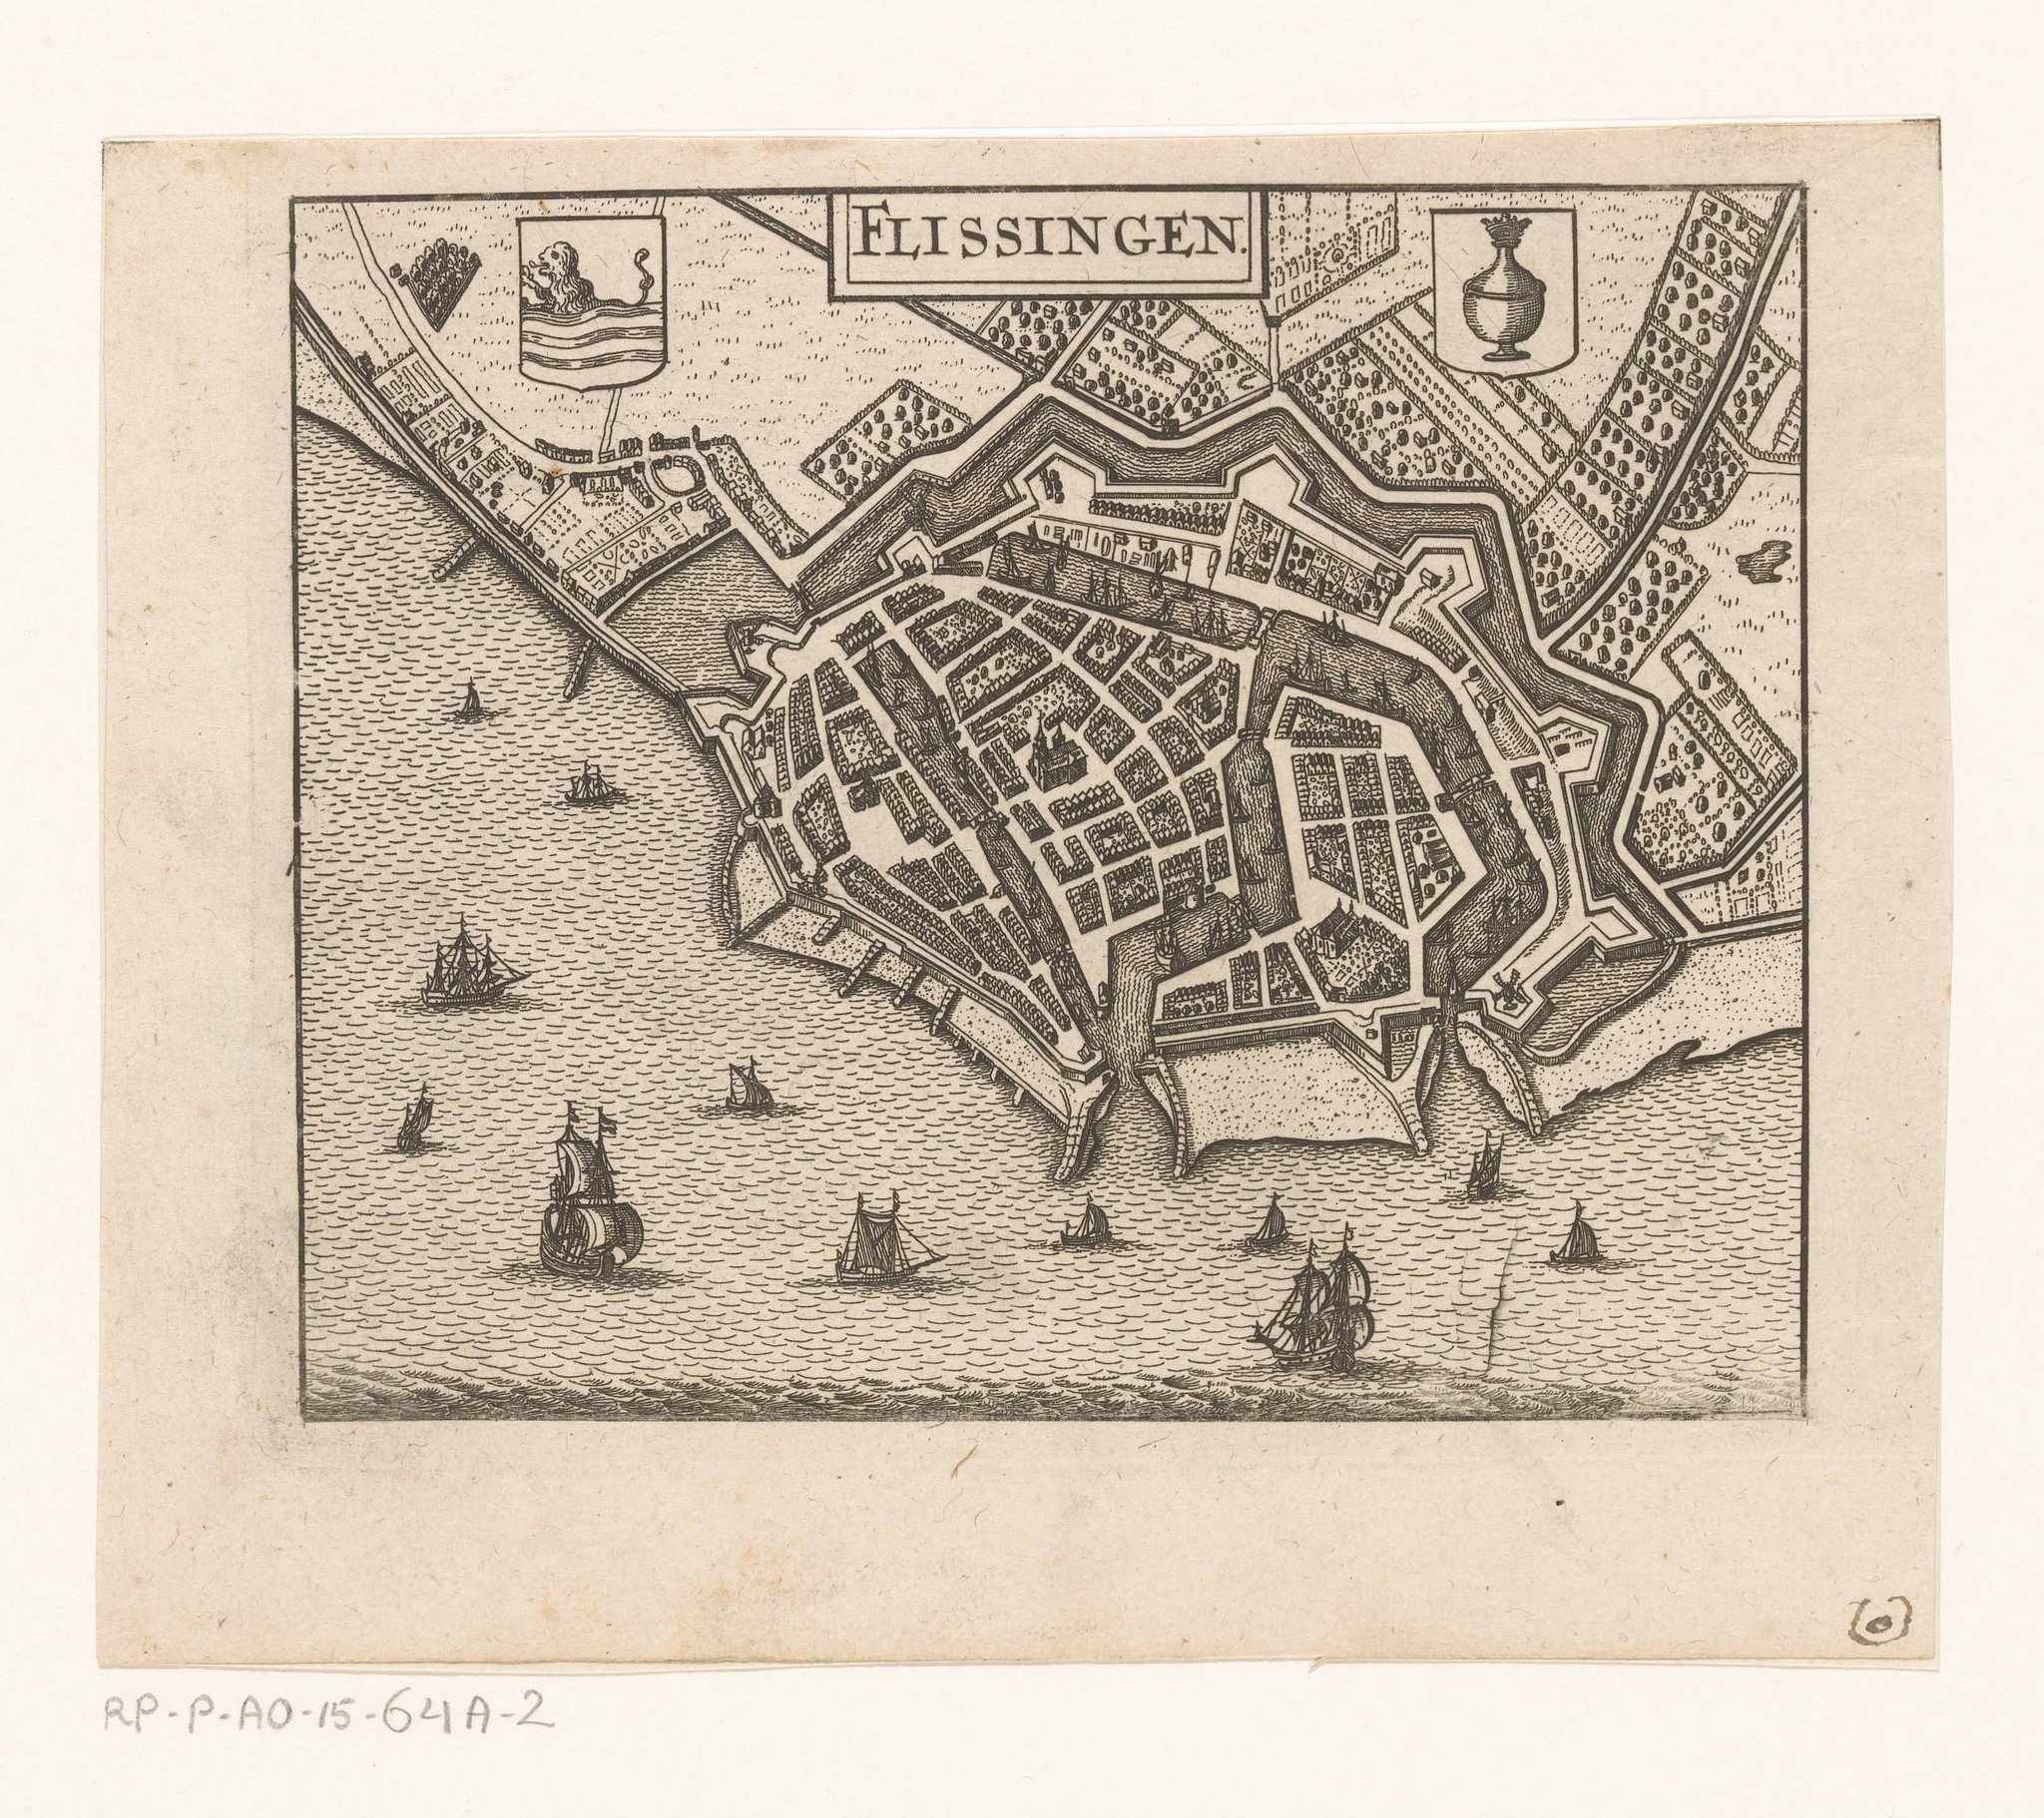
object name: area plan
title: Plattegrond van Vlissingen, 1500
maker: Anonymous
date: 1715-1755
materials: paper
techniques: etching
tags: coat of arms (as symbol of the state, etc.) (+ city; municipal), maps of cities, coat of arms (as symbol of the state, etc.) (+ province; provincial), flushing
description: Prent ook gebruikt in: Gargon, Mattheus. Walchersche arkadia, waar in op een zoetvoerigen trant (…). 2 delen. Leiden: Samuel Luchtmans, 1715-1717, dl. 1 (1715), p. 265. En in: Gargon, Mattheus. Walchersche arkadia, waar in op een zoetvoerigen trant (…). 2 delen. Leiden: Samuel Luchtmans en Zoon, 1746, dl. 1, p. 265. En in: Gargon, Mattheus. Walchersche arkadia, waar in op een zoetvoerigen trant (…). 2 delen. Middelburg: M.H. en A.L. Callenfels, S. Mandelgreen, P. Gillissen en L. Taillefert, 1755, dl. 1, p. 265.